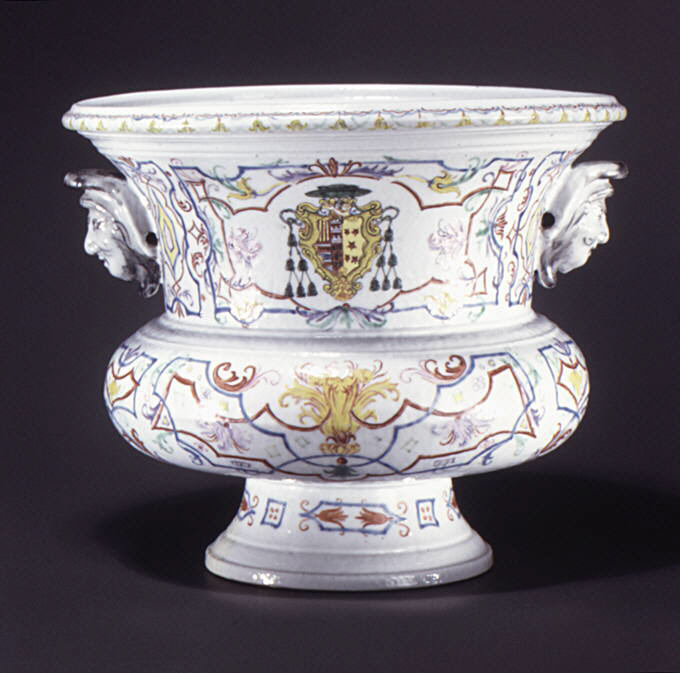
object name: wine cooler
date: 1801-1900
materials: hard paste porcelain